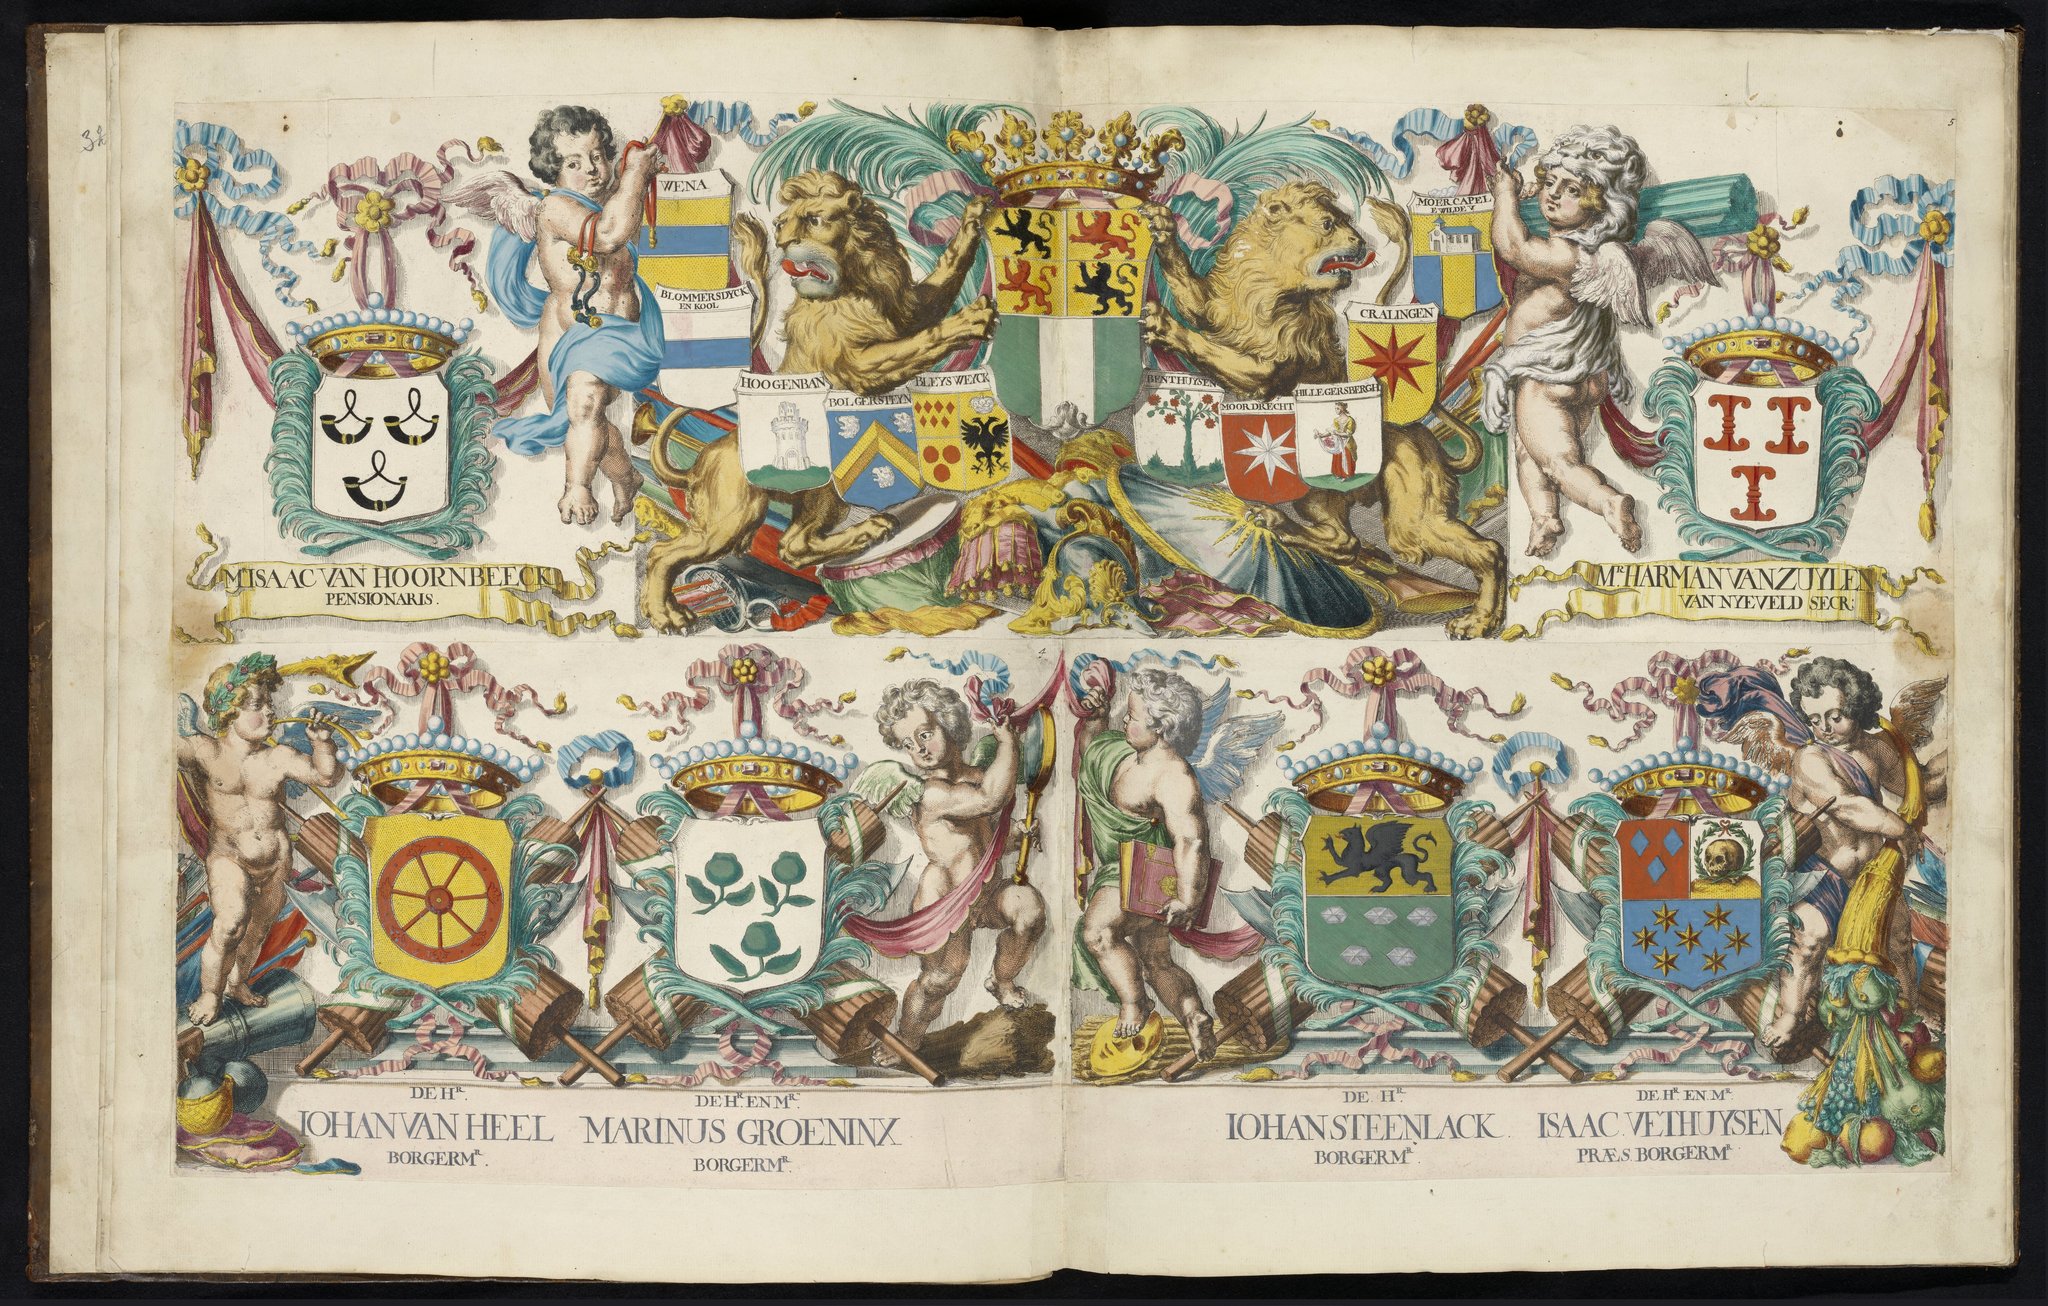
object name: print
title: Bovenstuk van de kaart van Rotterdam uit 1694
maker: romeyn de hooghe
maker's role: draughtsman, goldsmith, painter, print maker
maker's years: 1645-1708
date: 1694-1695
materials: paper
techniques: colour, etching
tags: mayor, coat of arms (as symbol of the state, etc.), cupids: 'amores', 'amoretti', 'putti', rotterdam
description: Voorstelling in vijf delen, in twee rijen. Midden boven het wapen van Rotterdam, geflankeerd door twee leeuwen. Daarbij de wapens van de gemeentes Wena, Blommersdyck en Kool, Hoogenban, Bolgersteyn, Bleysweyck, Benthuysen, Moordrecht, Hillergersbergh, Cralingen en Moercapel en Wilde Venen. Putti houden de wapens omhoog van de pensionaris Isaac van Hoornbeeck, secretaris Harman van Zuylen van Nyeveld, en de vier burgemeesters genaamd: Johan van Heel, Marinus Groeninx, Johan Steenlack en Isaac Vethuysen. Achter de wapens van de vier burgemeesters liggen fasces. De putti hebben een muziekinstrument, spiegel, boek en hoorn des overvloeds in hun handen. De voorstelling is onderdeel van de kaart van Rotterdam door Johannes de Vouw en maakt deel uit van een album.